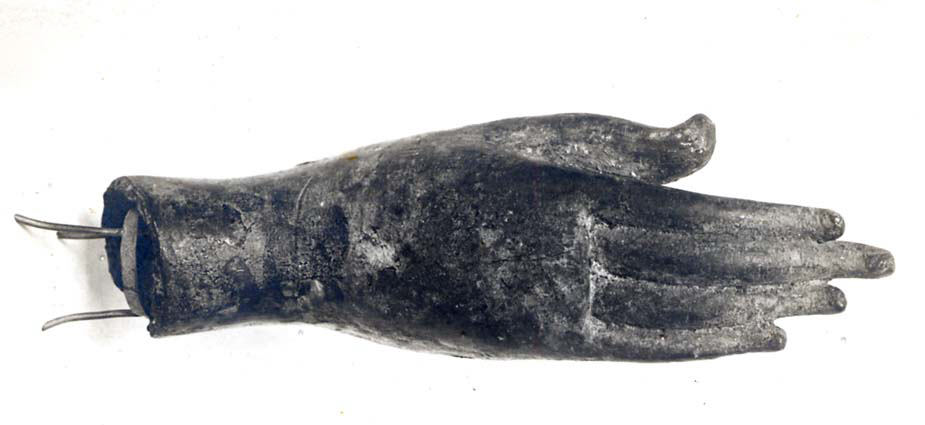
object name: hand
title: Right Hand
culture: thai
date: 1401-1500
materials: bronze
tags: hands